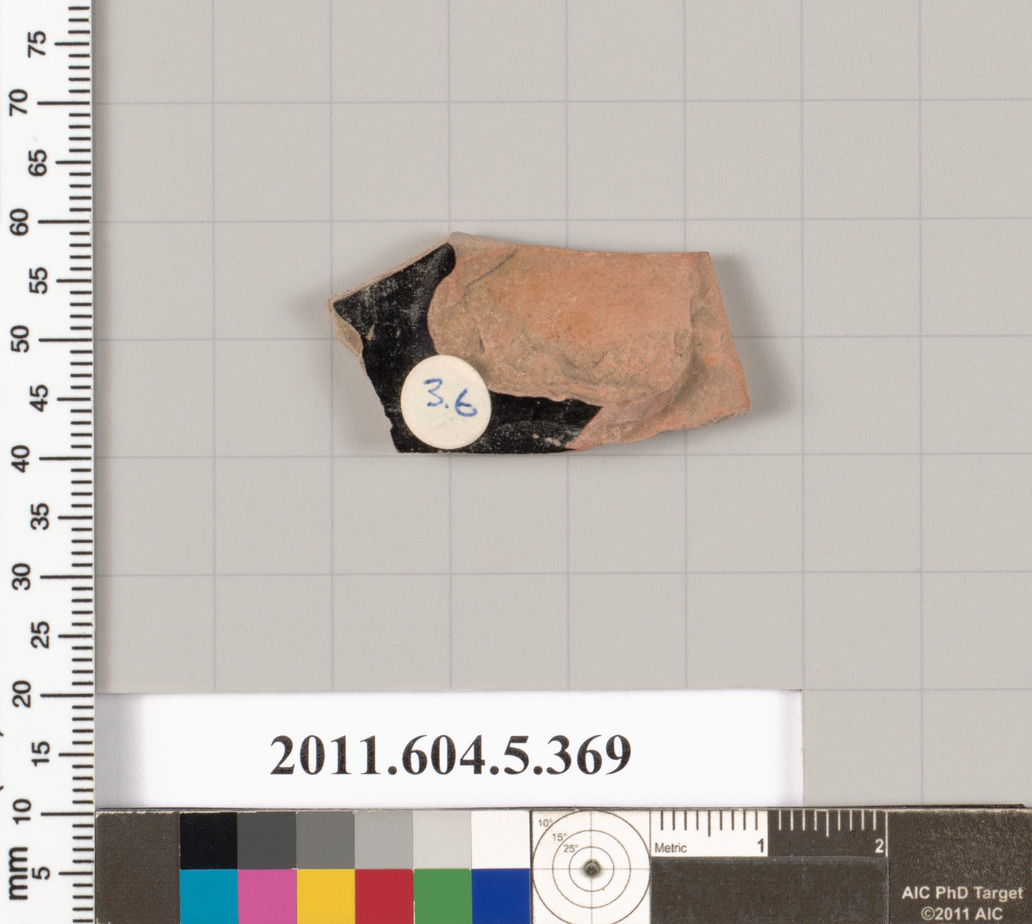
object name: kylix fragment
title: Terracotta fragment of a kylix (drinking cup)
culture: greek, attic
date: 600-401 BCE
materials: terracotta